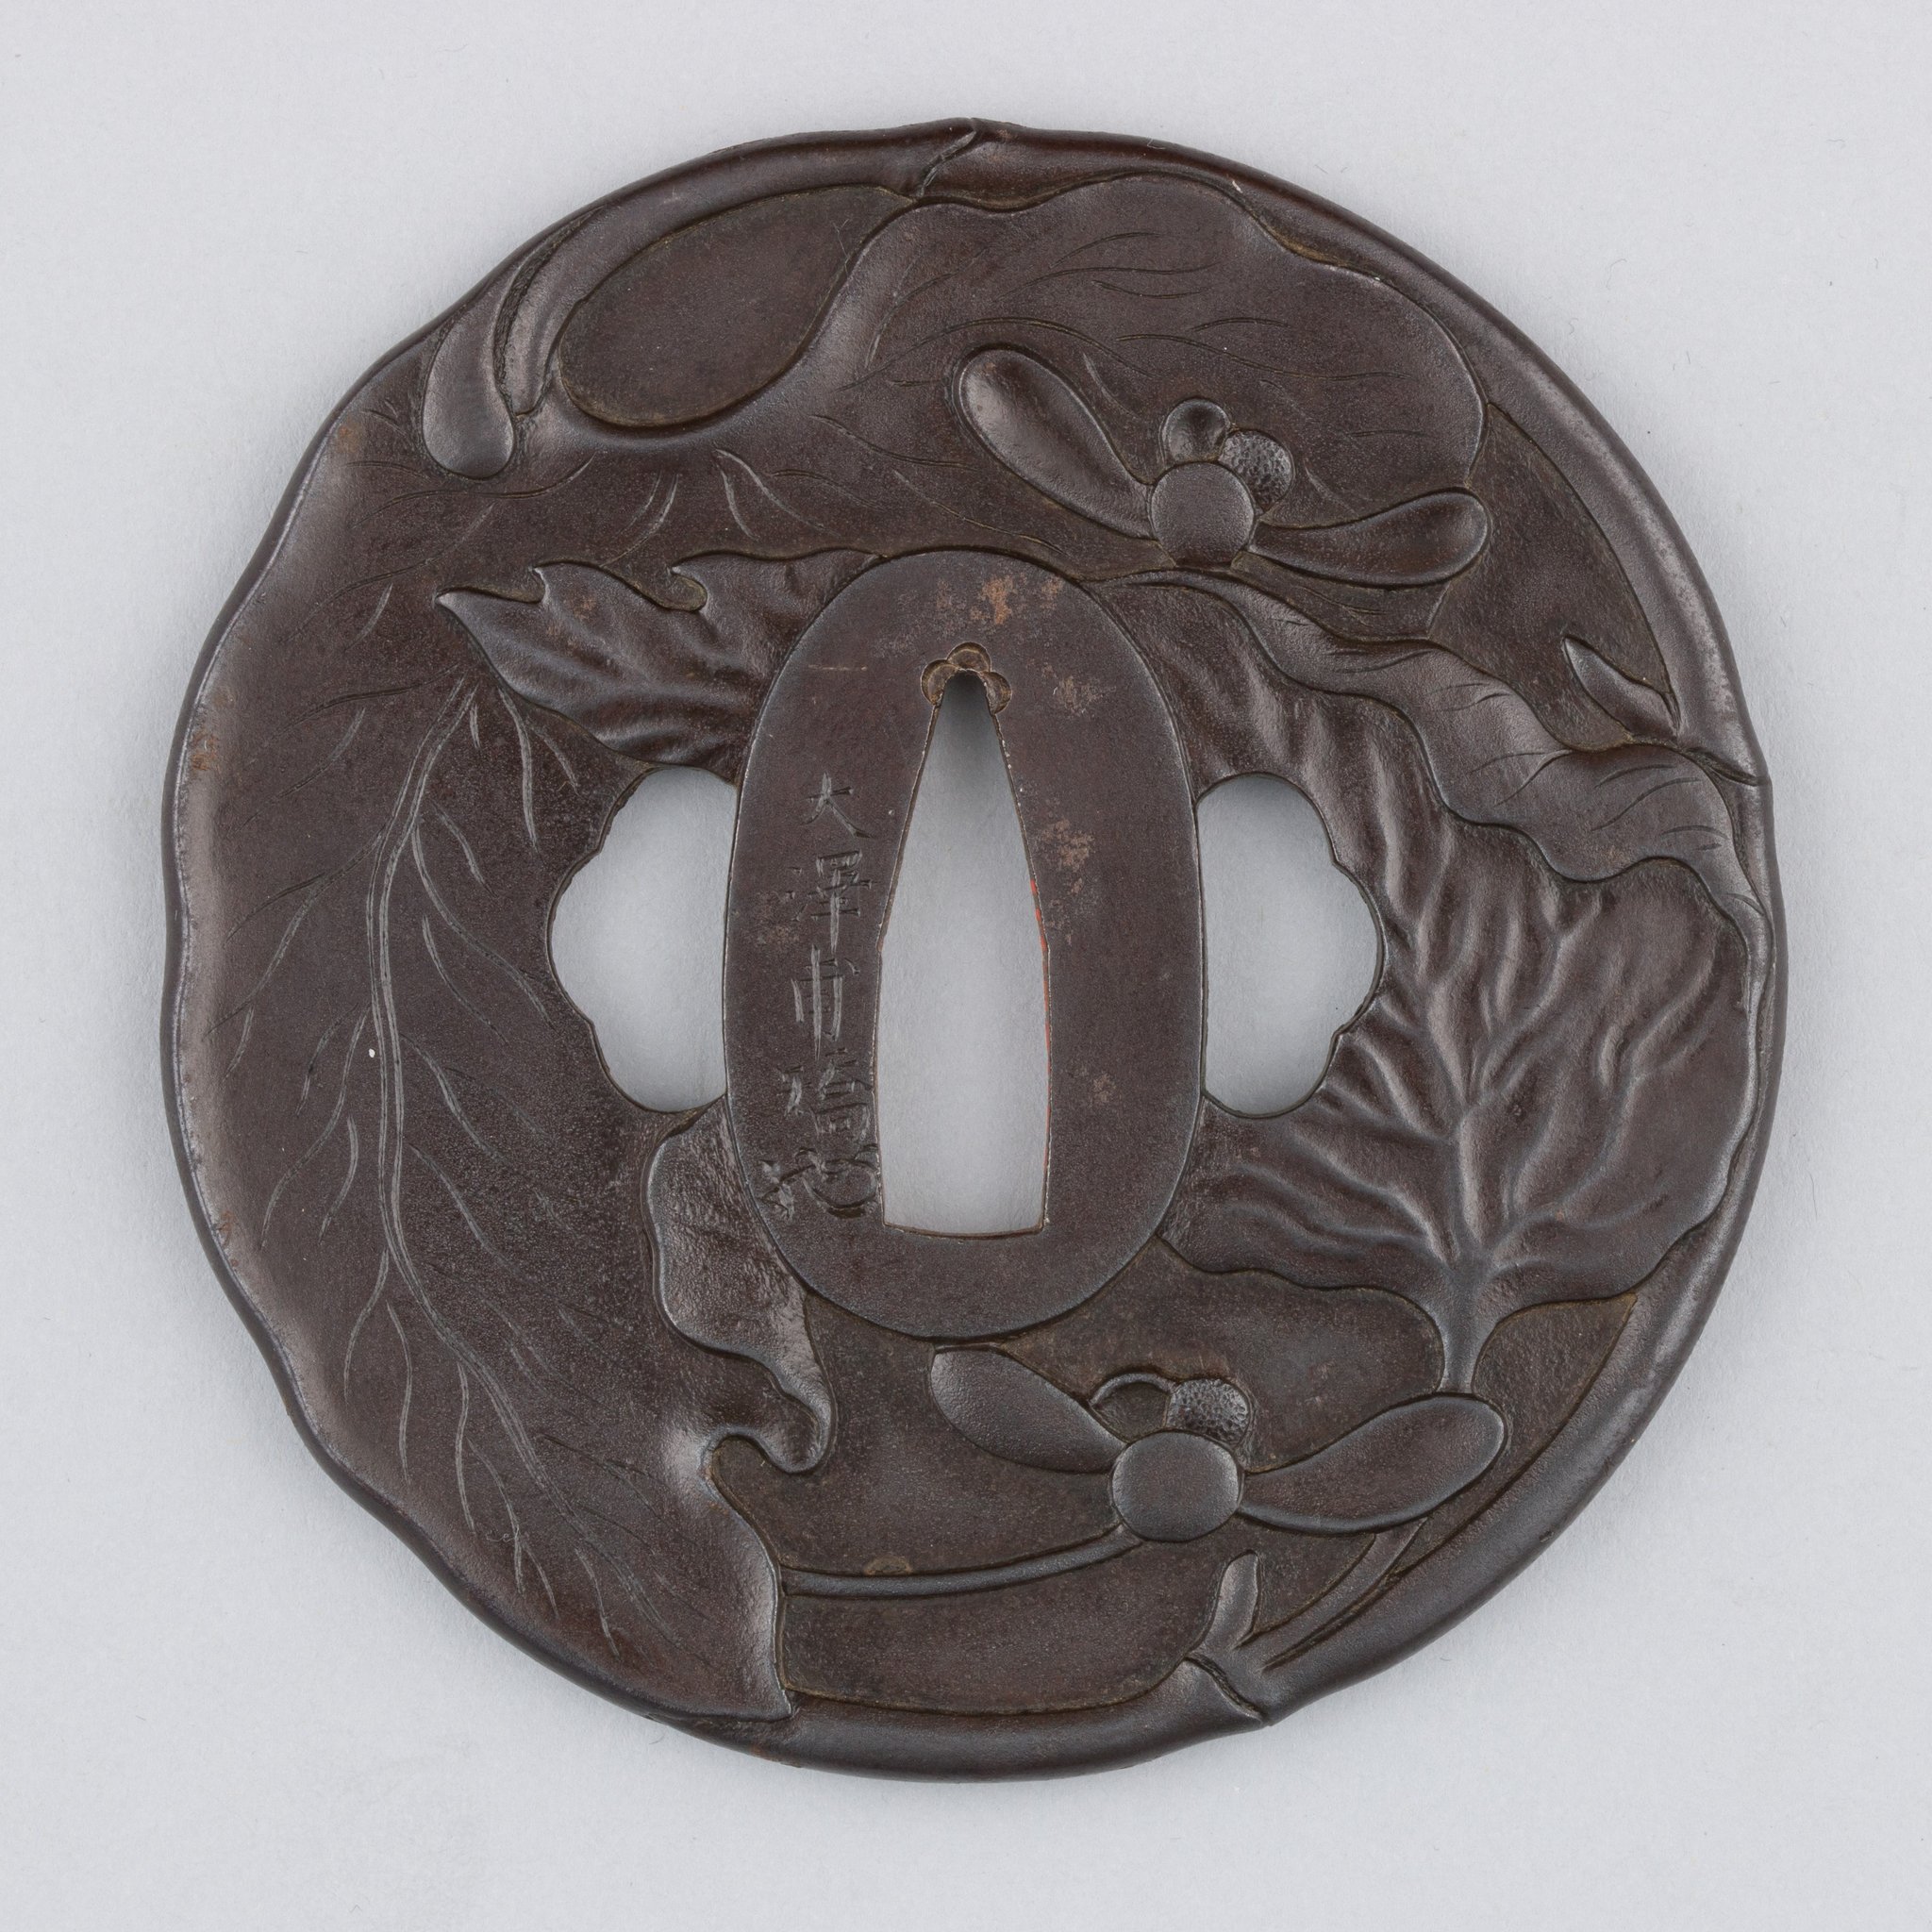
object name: sword guard tsuba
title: Sword Guard (Tsuba)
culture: japanese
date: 1767-1800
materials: iron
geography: japan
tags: leaves